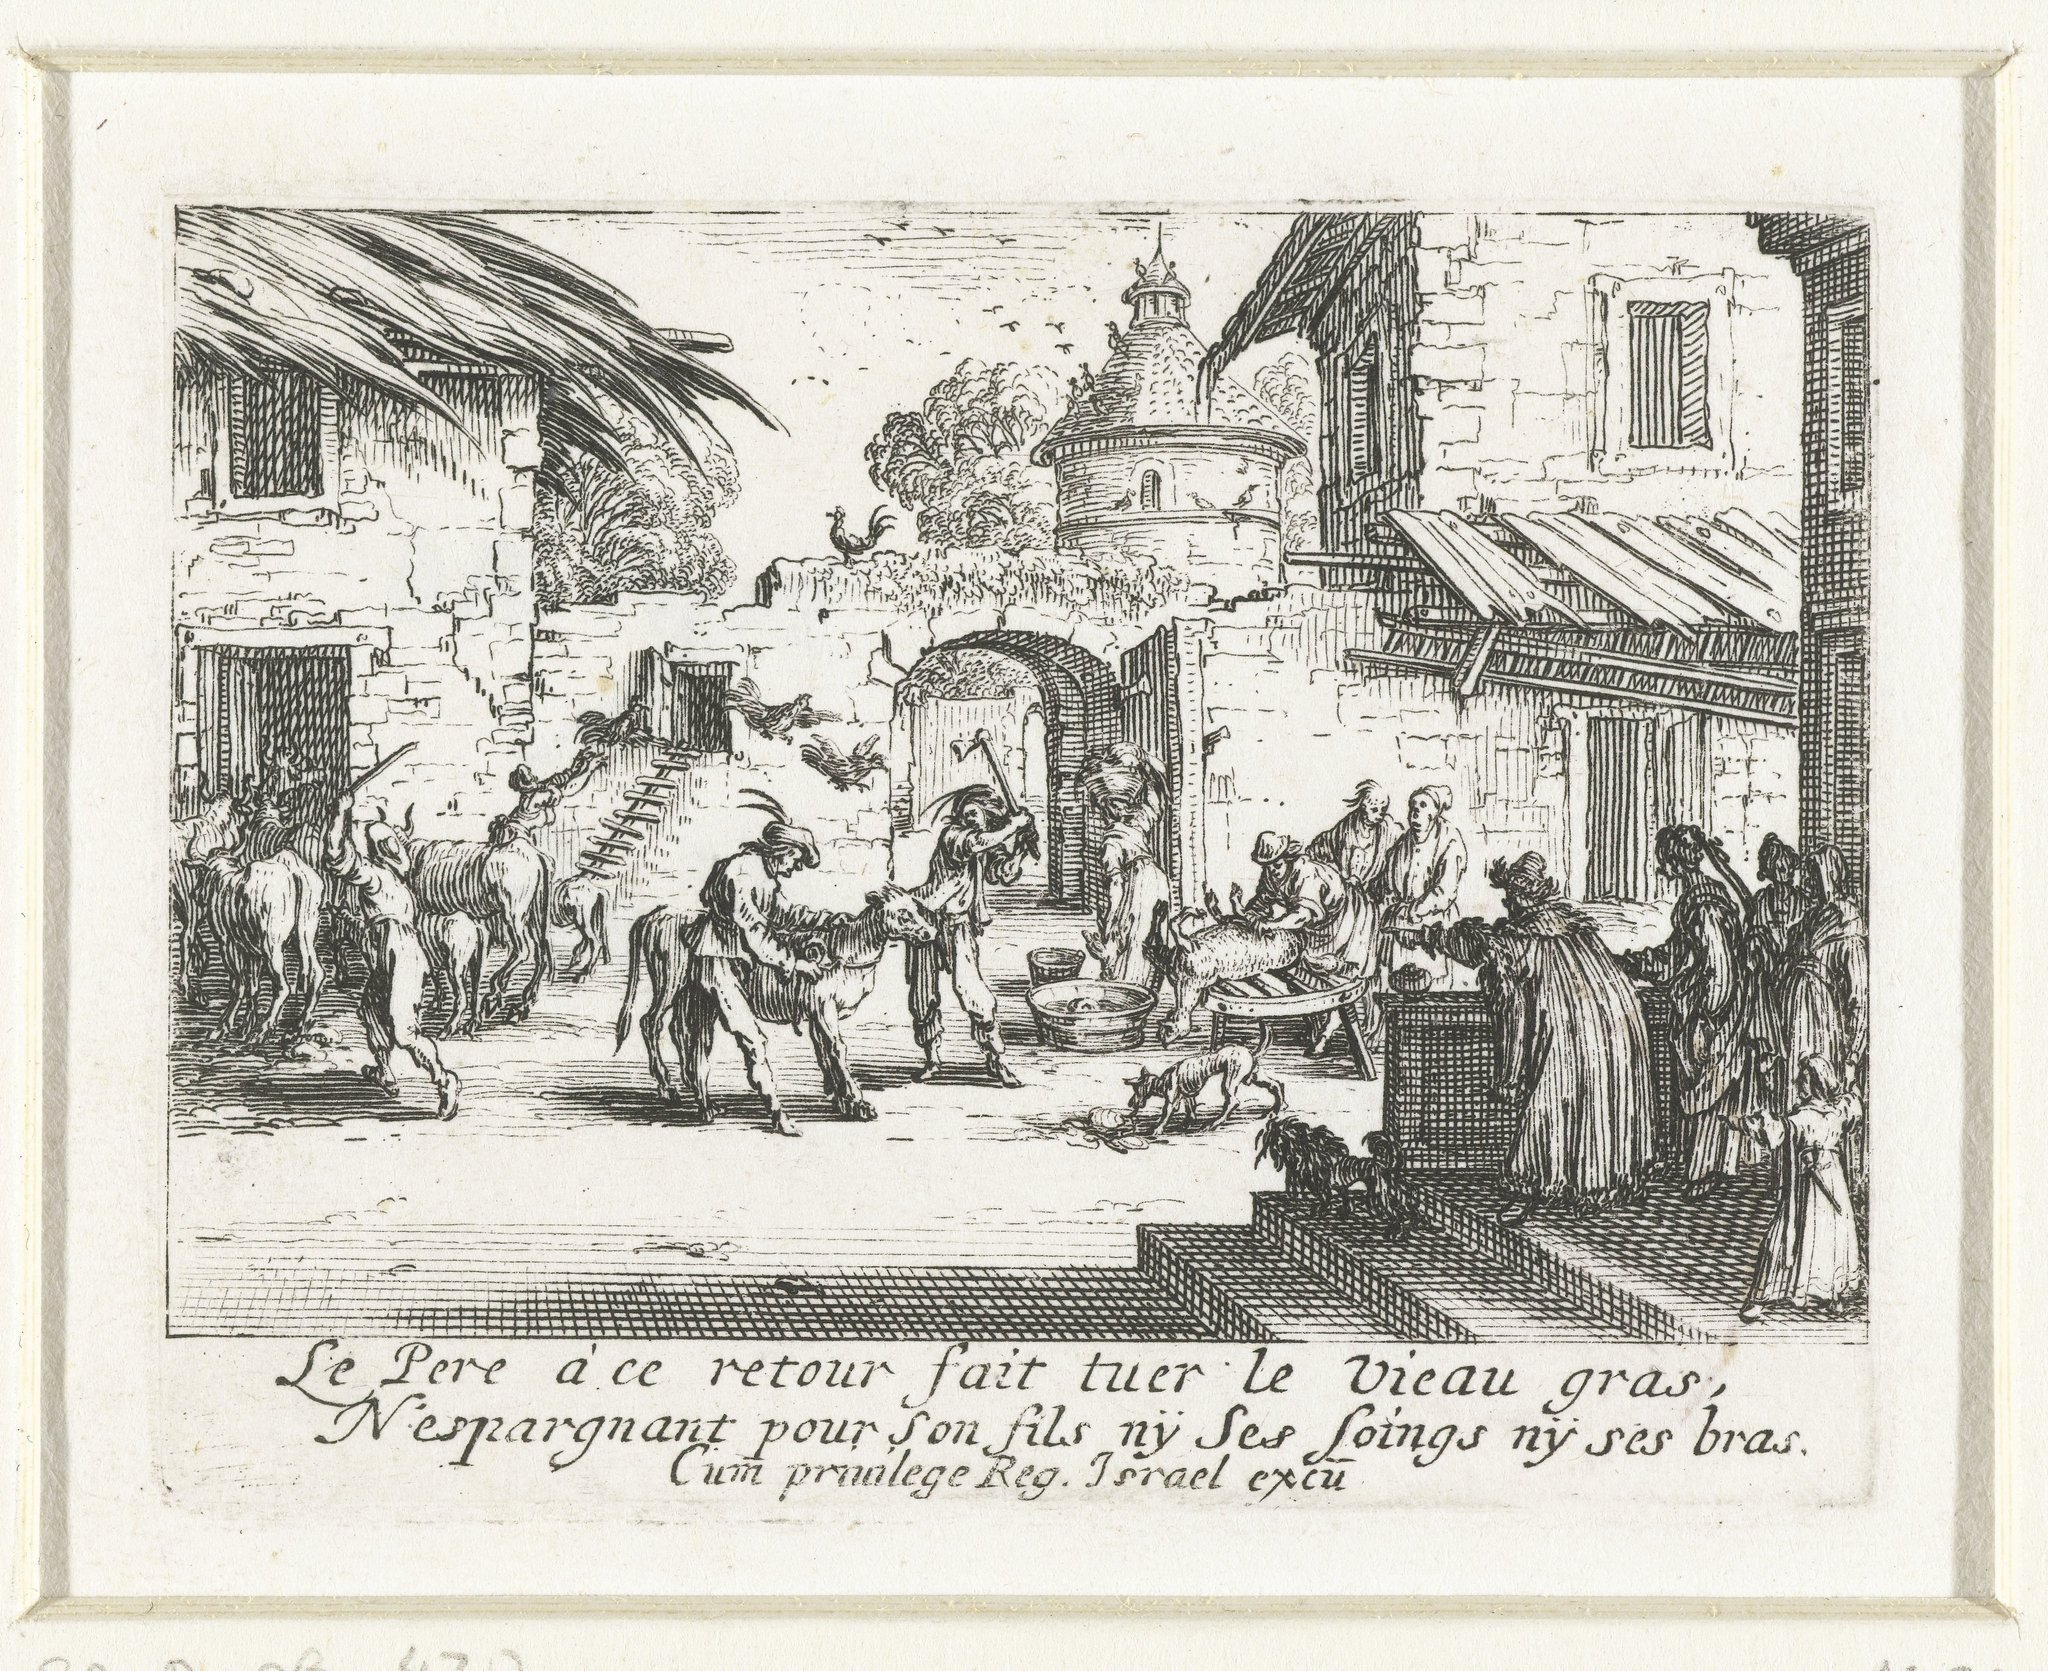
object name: print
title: Het vetgemeste kalf wordt geslacht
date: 1635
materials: paper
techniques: etching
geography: paris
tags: preparations, e.g. the prodigal son is given new robes; slaughtering of the fatted calf; the elder son objects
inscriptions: collector's mark: Lugt 240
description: Onder het toeziend oog van de vader (op de voorgrond rechts) wordt ter gelegenheid van de terugkeer van de verloren zoon een vet kalf geslacht op de binnenplaats bij het huis. Onder de voorstelling een tweeregelig Franstalig vers. Deze prent is onderdeel van een reeks prenten rond de gelijkenis van de verloren zoon, bestaande uit een titelprent en tien verhalende voorstellingen.